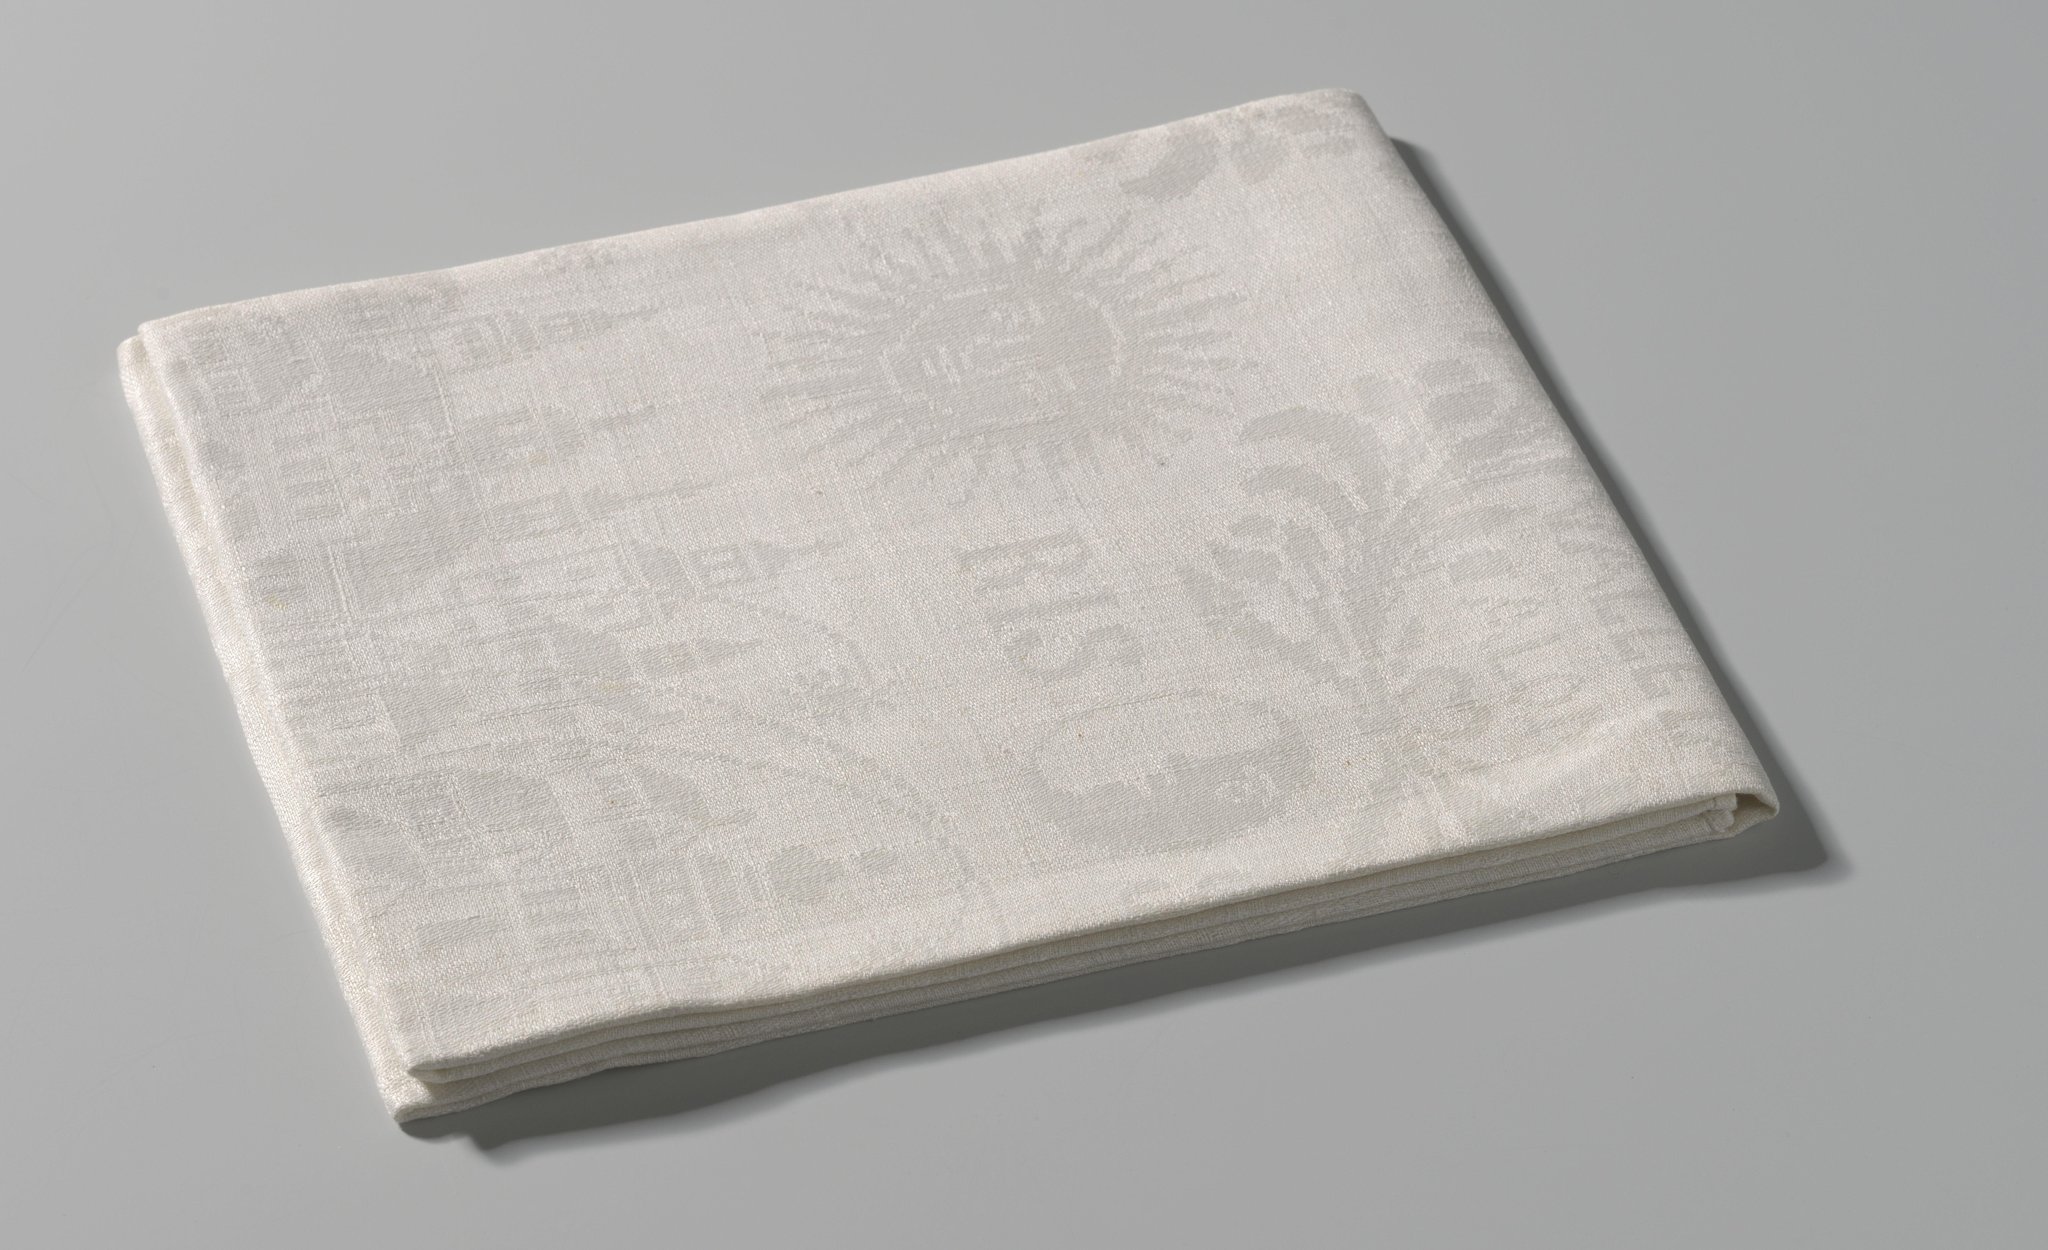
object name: tablecloth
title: Fragment van een tafellaken met de inname van Rijssel door Eugenius van Savoye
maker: Anonymous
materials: linen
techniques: damask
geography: kortrijk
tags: paris, vienna, eugenius van savoye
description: Fragment van een tafellaken van linnendamast met de inname van Rijssel door Eugenius van Savoye. Twee ruiters met het bijschrift: EGENIUS. In drie kransen de tekst: SISTE SOL IN GIBEON, ET LUNA IN VALLE...IA-ALON (Blijf staan, zon, te Gibeon en gij, maan, in het dal van Ajalon, Josua 9:13), de zon en de maan en het bijschrift: RIS-SEL. Staande randen: Doorlopende ranken.